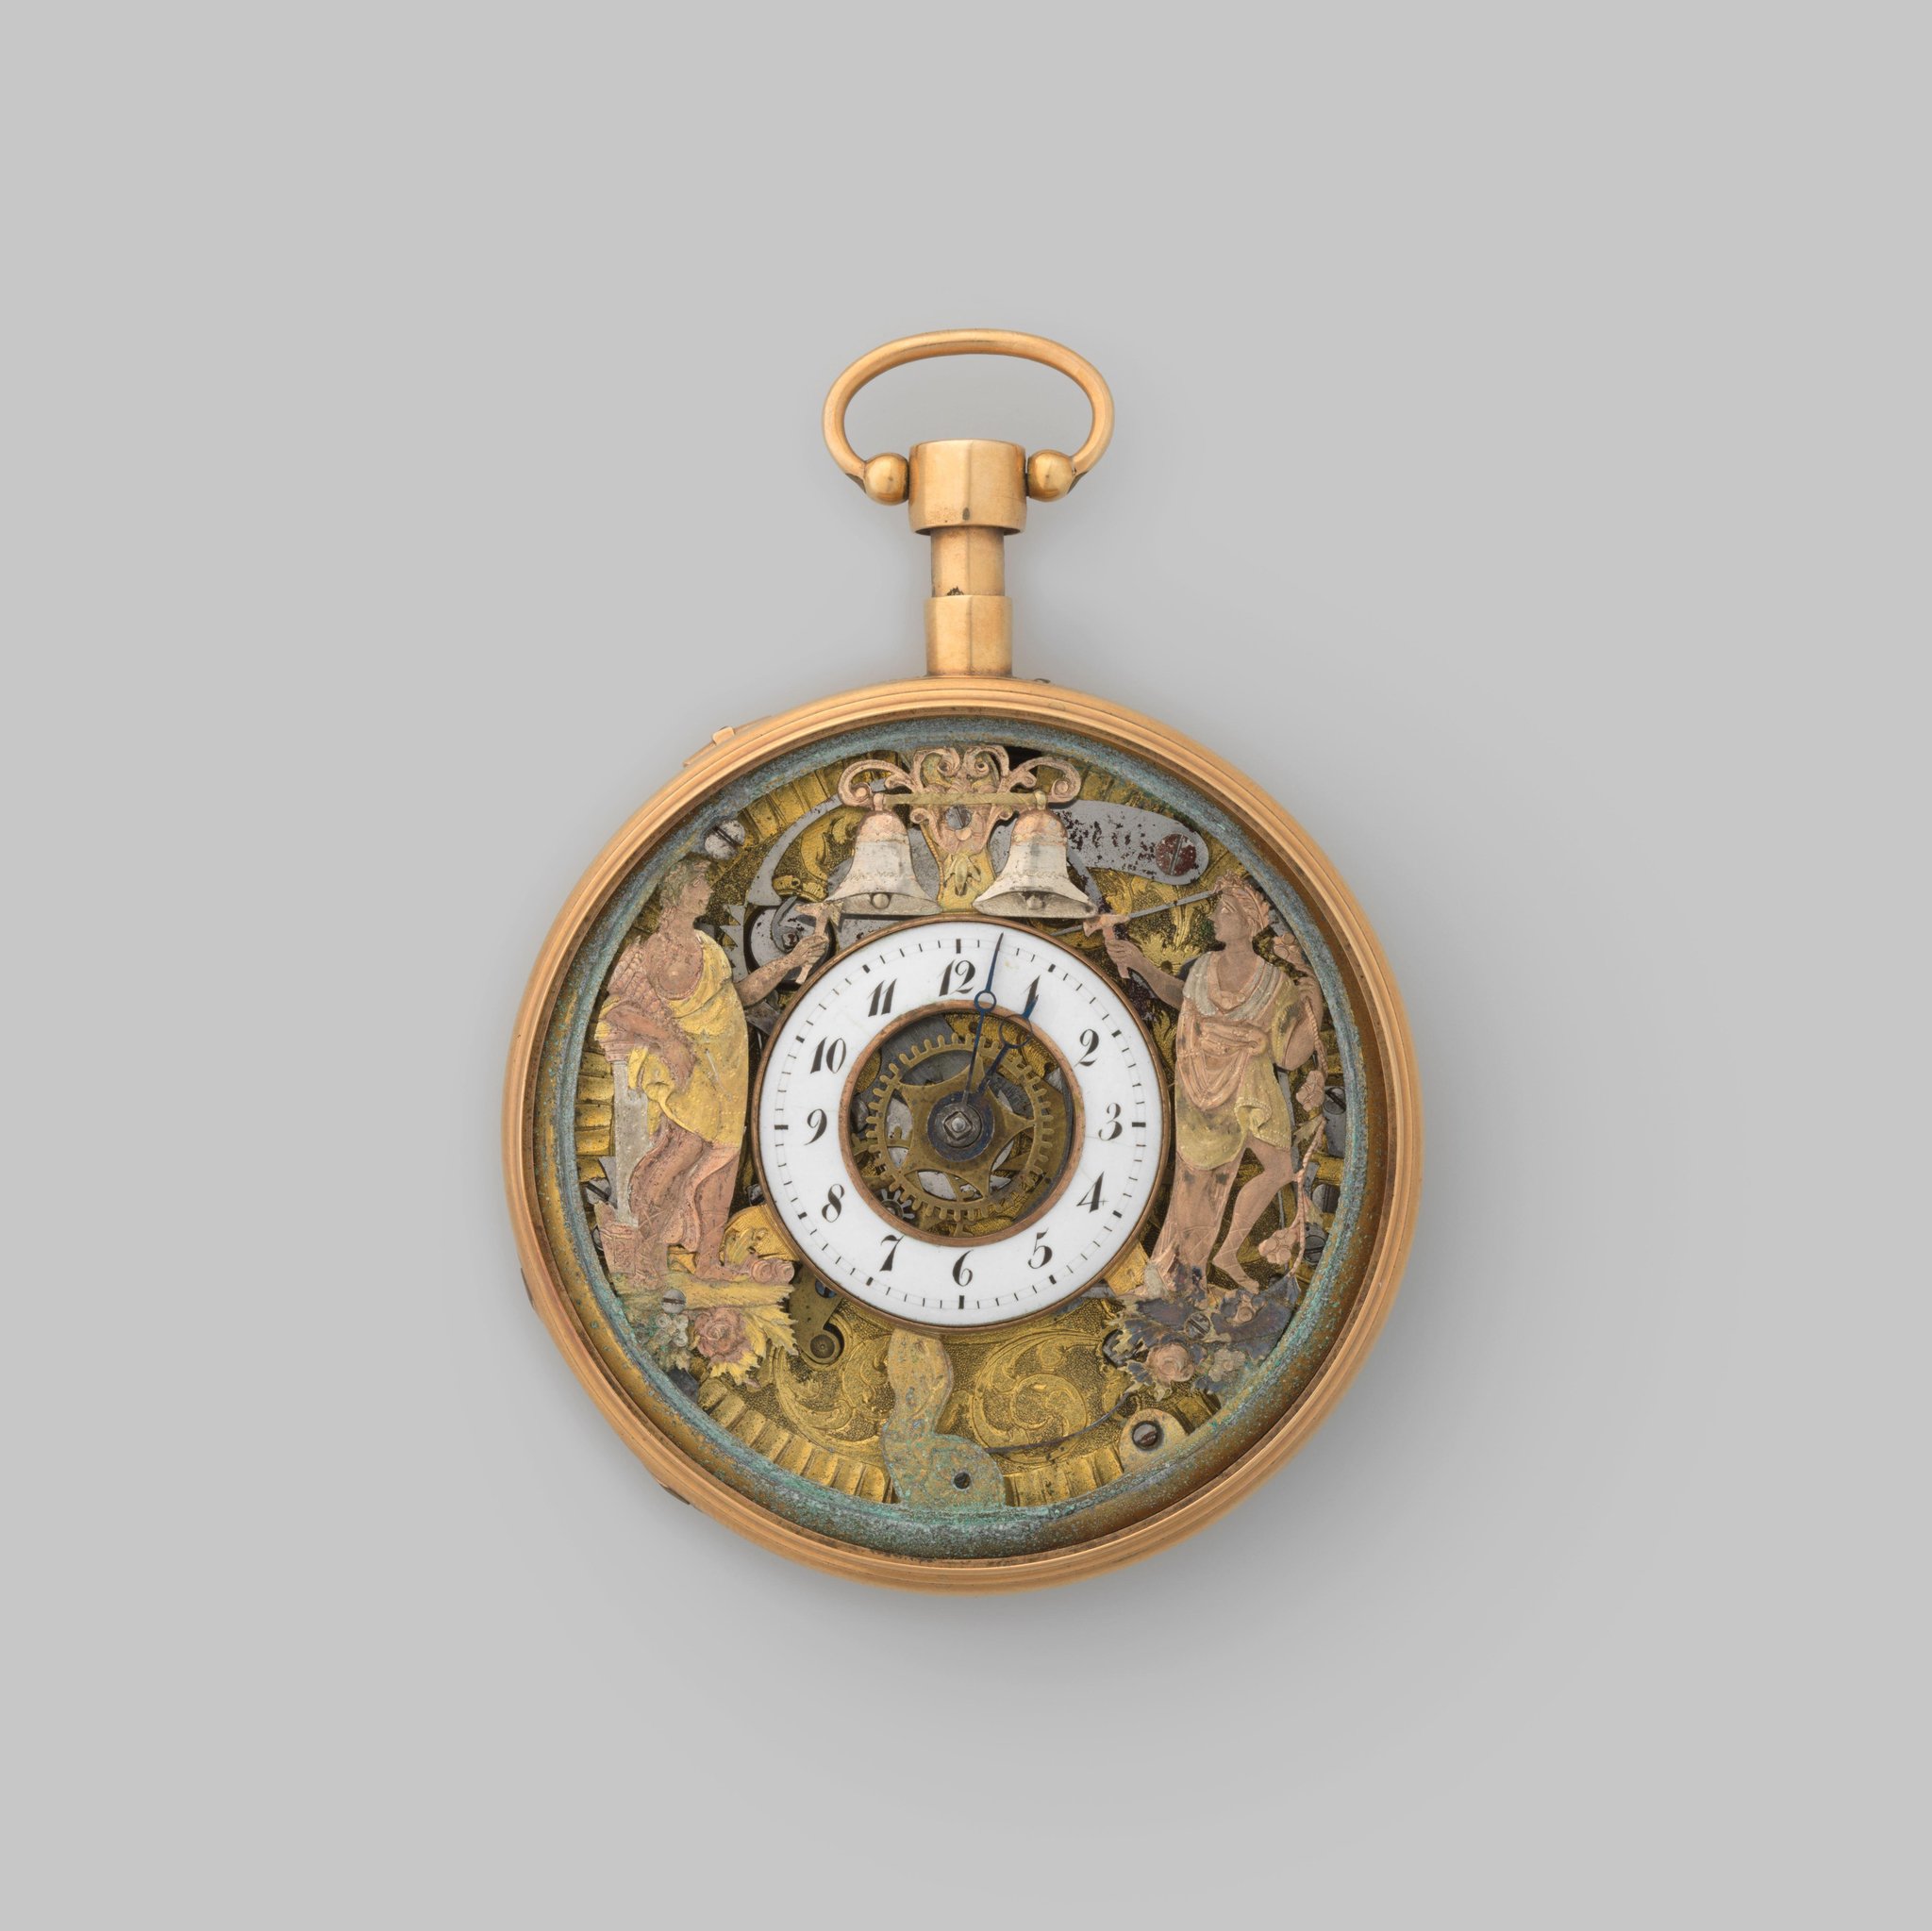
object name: wrist watch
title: Herenhorloge van goud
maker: Anonymous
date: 1800-1815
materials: gold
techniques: enameling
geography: switzerland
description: Herenhorloge, repetitiehorloge, van goud met beweegbare figuren in 'quatre couleurs'. In het midden een wit geëmailleerde cijfering geflankeerd door twee figuren in Romeinse kleding. De achterbodem is glad.